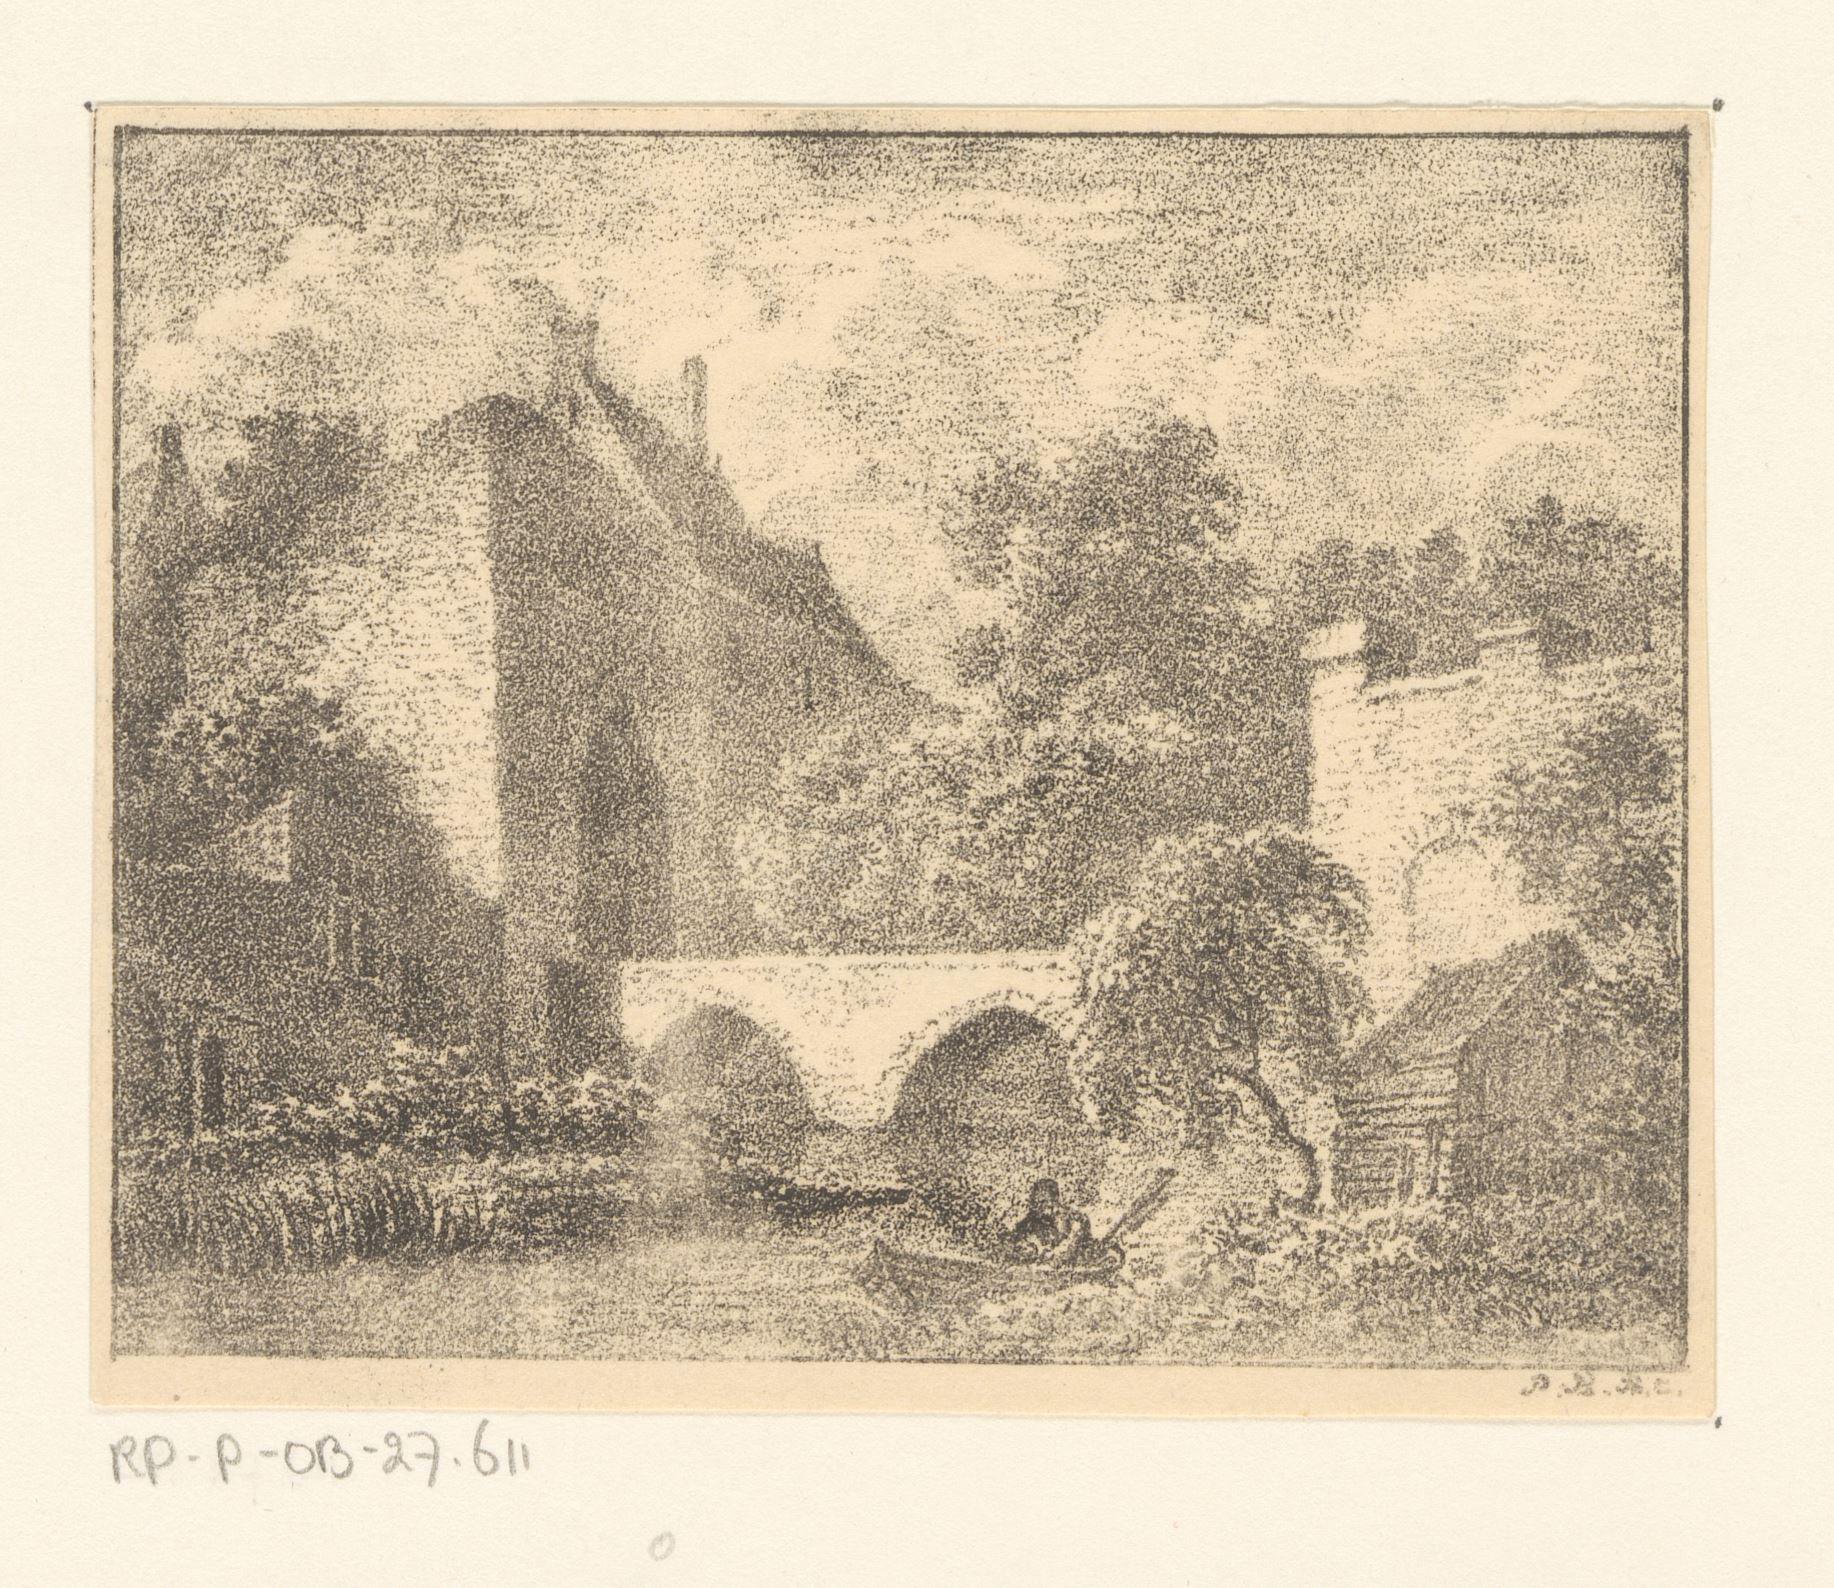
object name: print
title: Landschap met fort en brug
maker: pieter bartholomeusz. barbiers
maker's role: draughtsman, print maker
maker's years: 1772-1837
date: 1809-1837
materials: paper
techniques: lithograph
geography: haarlem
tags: towers ~ fortified city, bridge in city across river, canal, etc.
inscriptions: collector's mark: Lugt 2228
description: Op het water een boot met een roeiende figuur. Rechts van de brug een gebouw met kantelen, links van de brug de toegangpoort tot het fort. Op de rechteroever van de rivier staat een klein houten huis.